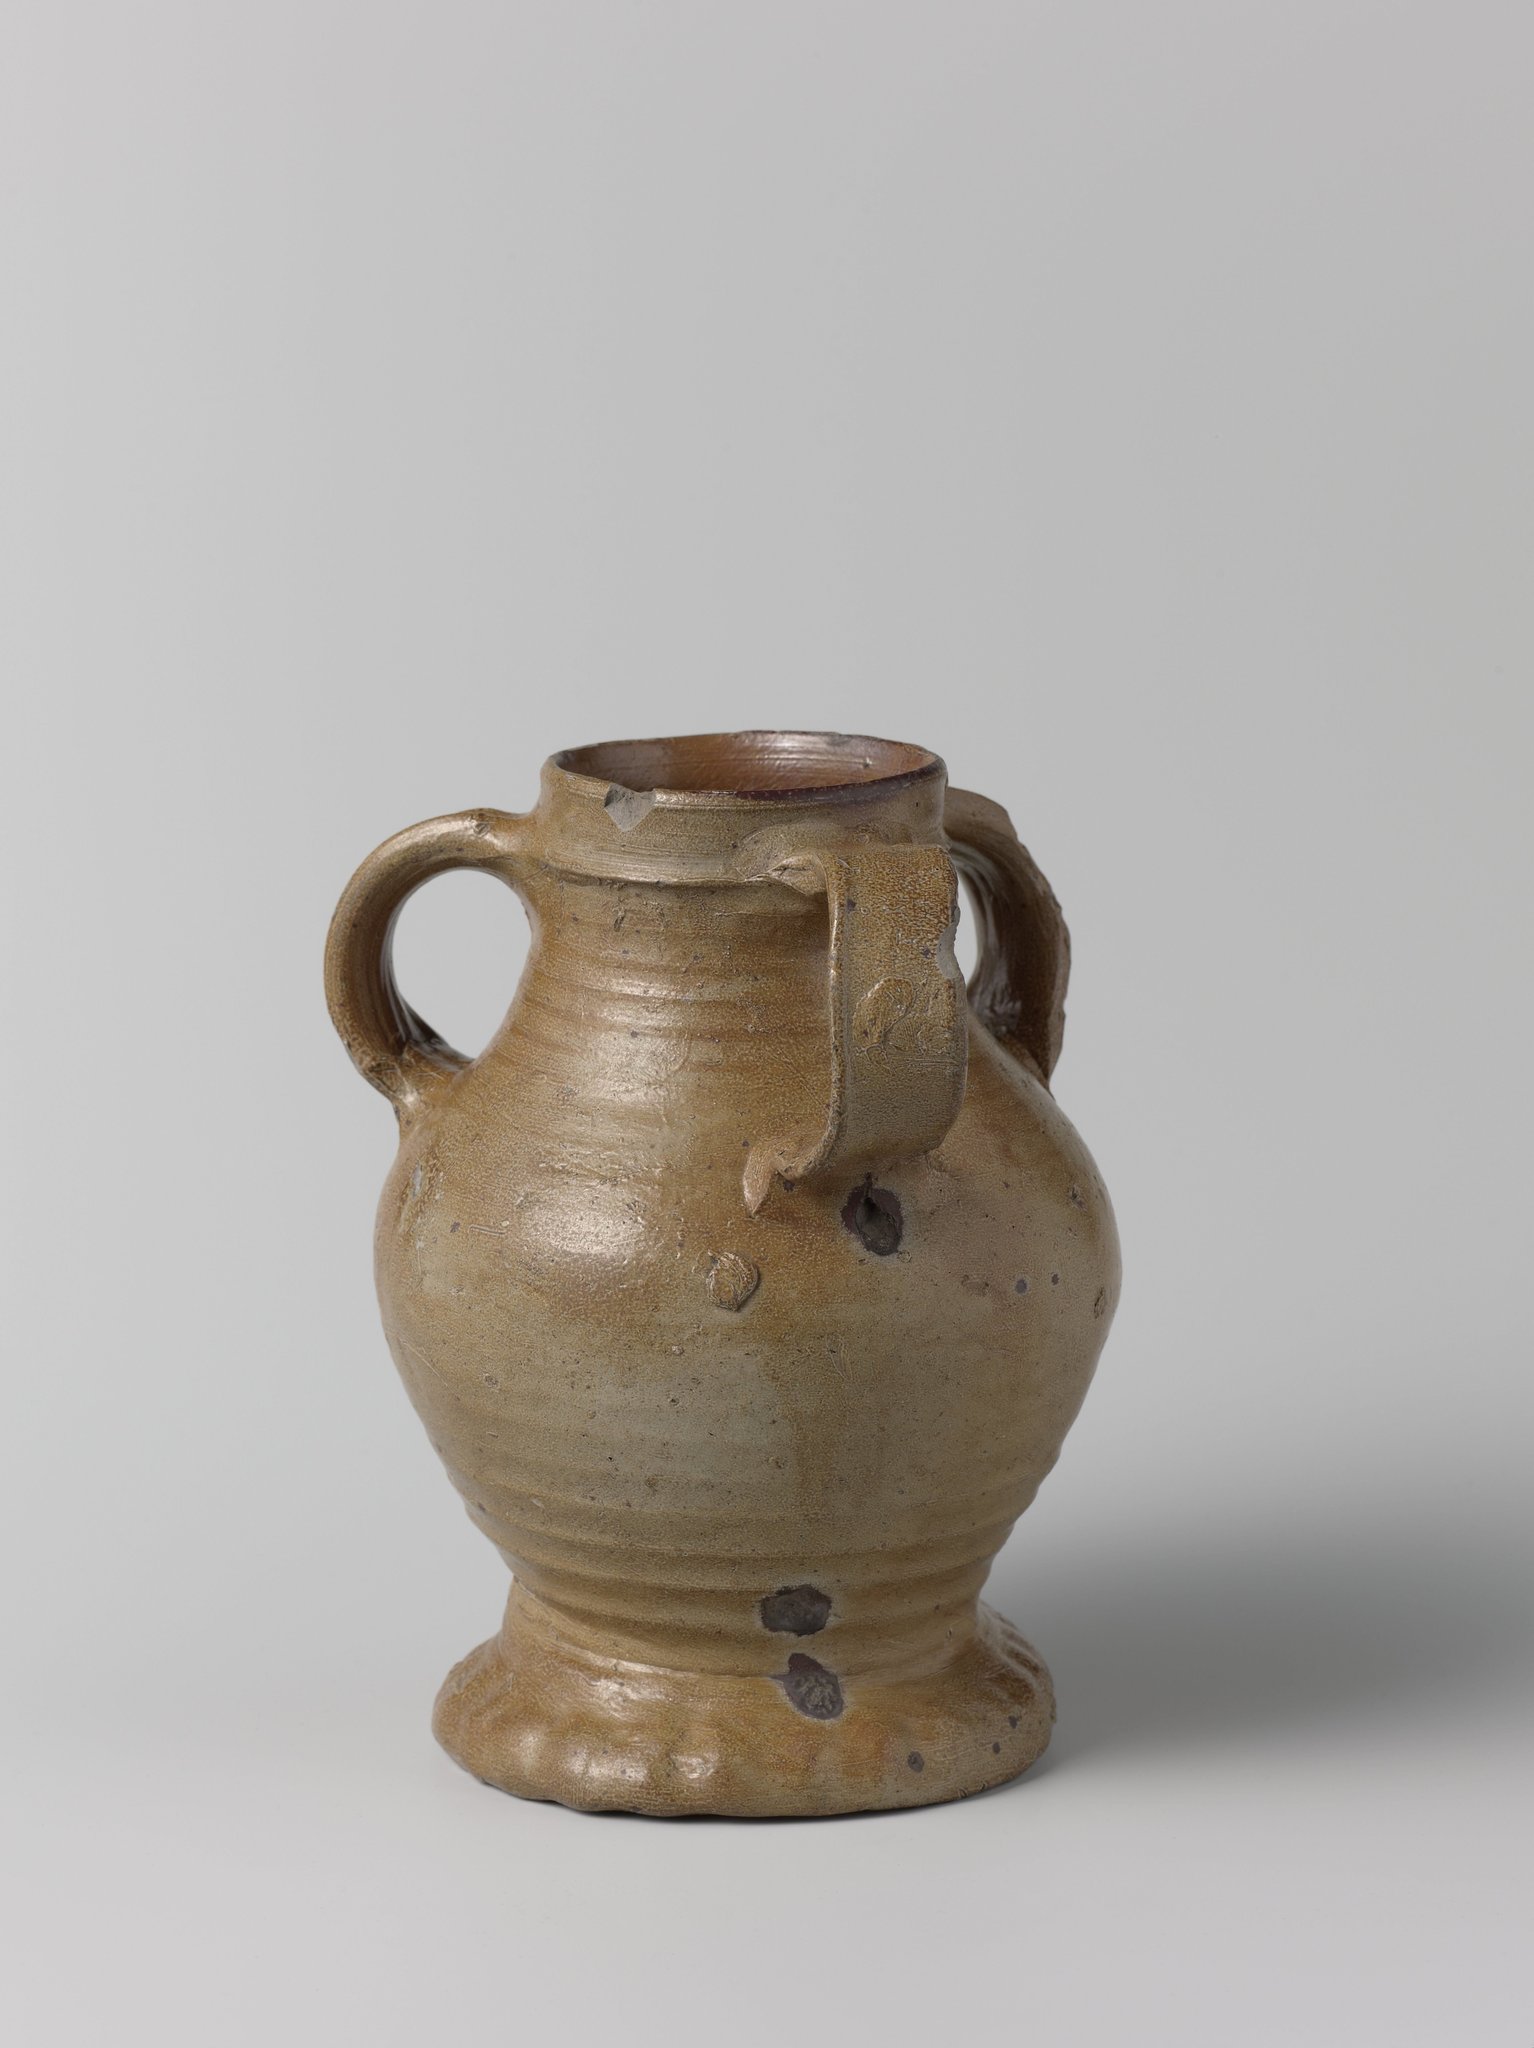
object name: jug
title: Jug with three handles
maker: Anonymous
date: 1550-1599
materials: engobe, glaze, stoneware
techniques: firing, forming, turning, vitrification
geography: raeren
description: Kruik van steengoed op gegolfde voet met een eivormig lichaam en wijde nek. Drie C-vormige oren bevestigd aan de nek en de schouder. Profiel op de nek. Bedekt met een bruine engobe. De kruik is versierd met draairingen op de buik en nek. Raeren.